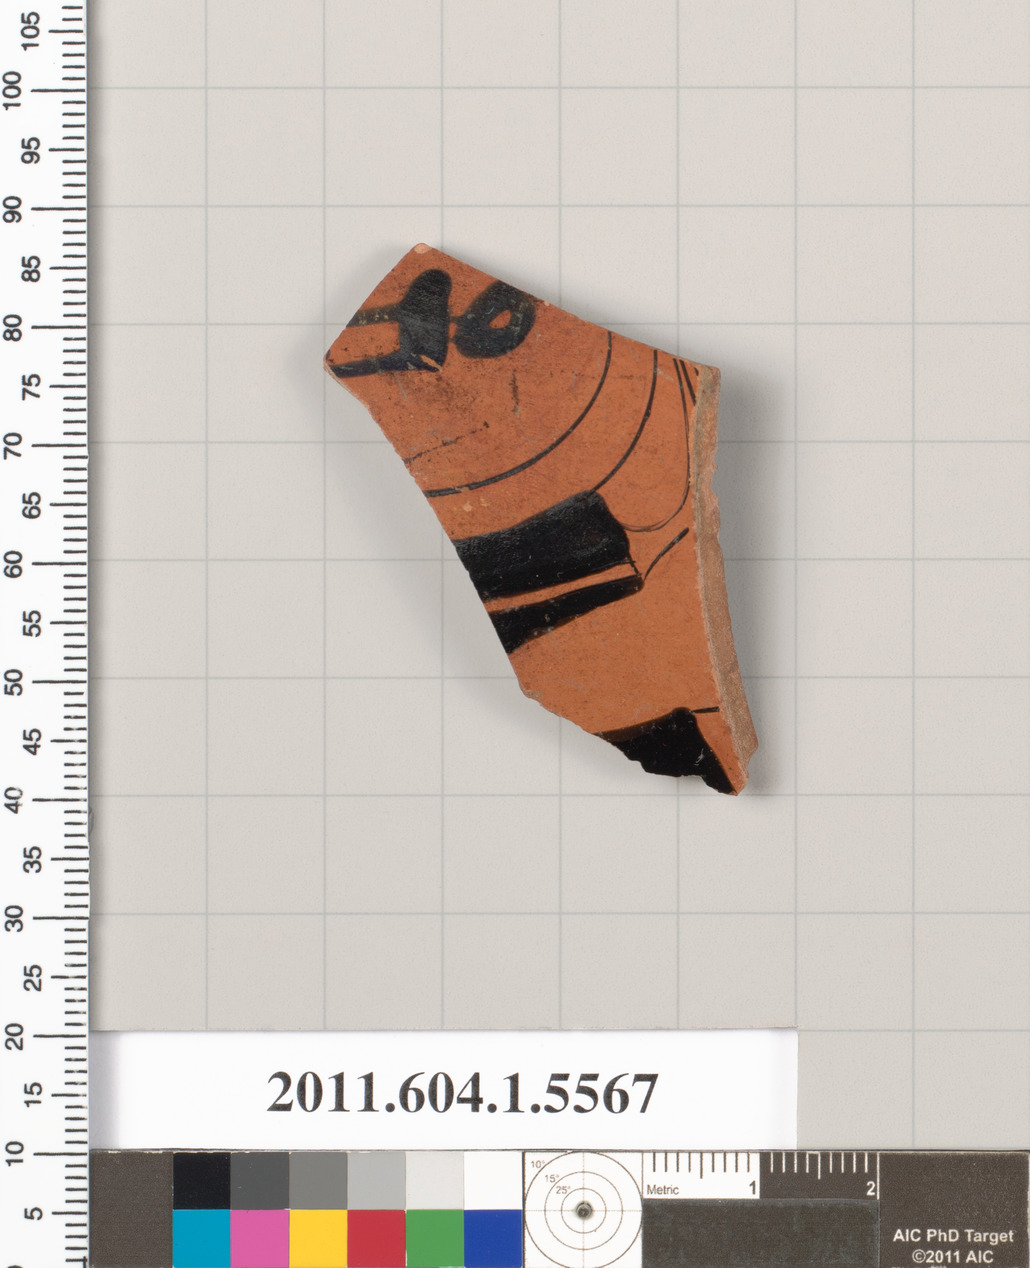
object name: kylix fragment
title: Terracotta fragment of a kylix (drinking cup)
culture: greek, attic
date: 500-490 BCE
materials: terracotta